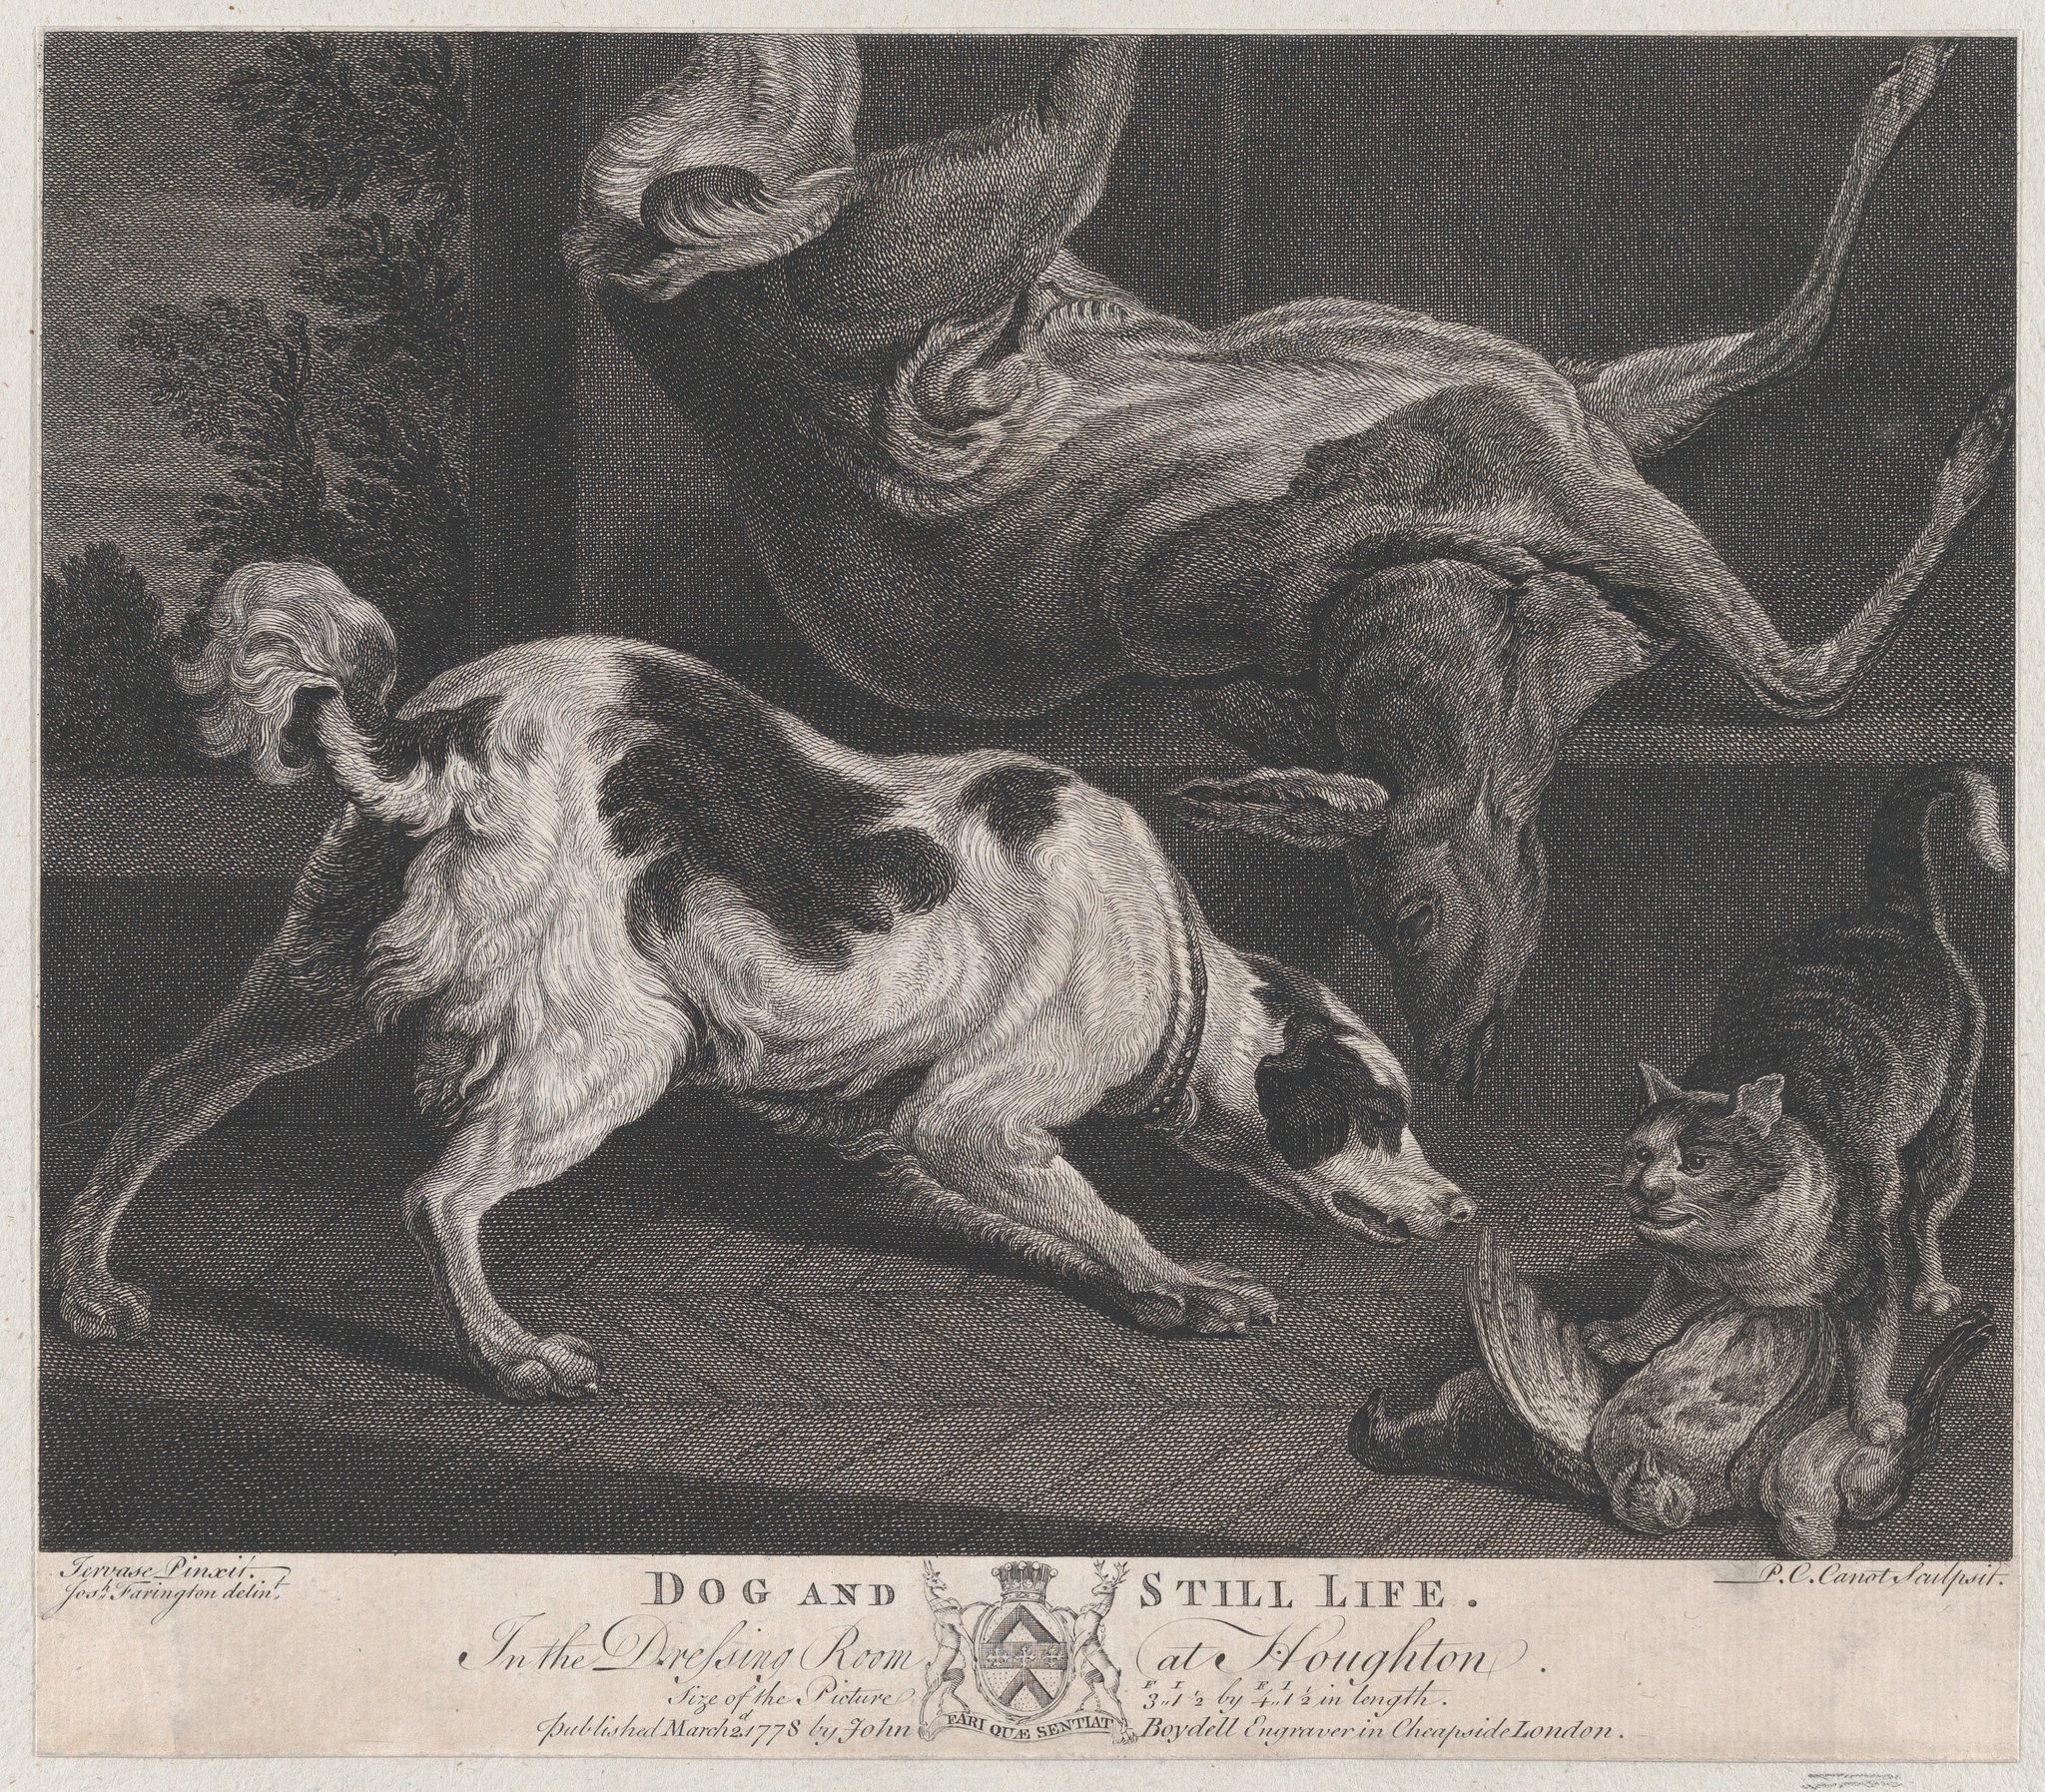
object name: print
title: Dogs and Still Life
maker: pierre charles canot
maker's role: engraver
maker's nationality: french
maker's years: 1710-1777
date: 1778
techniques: engraving, etching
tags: birds,cats,deer,dogs,still life,coat of arms